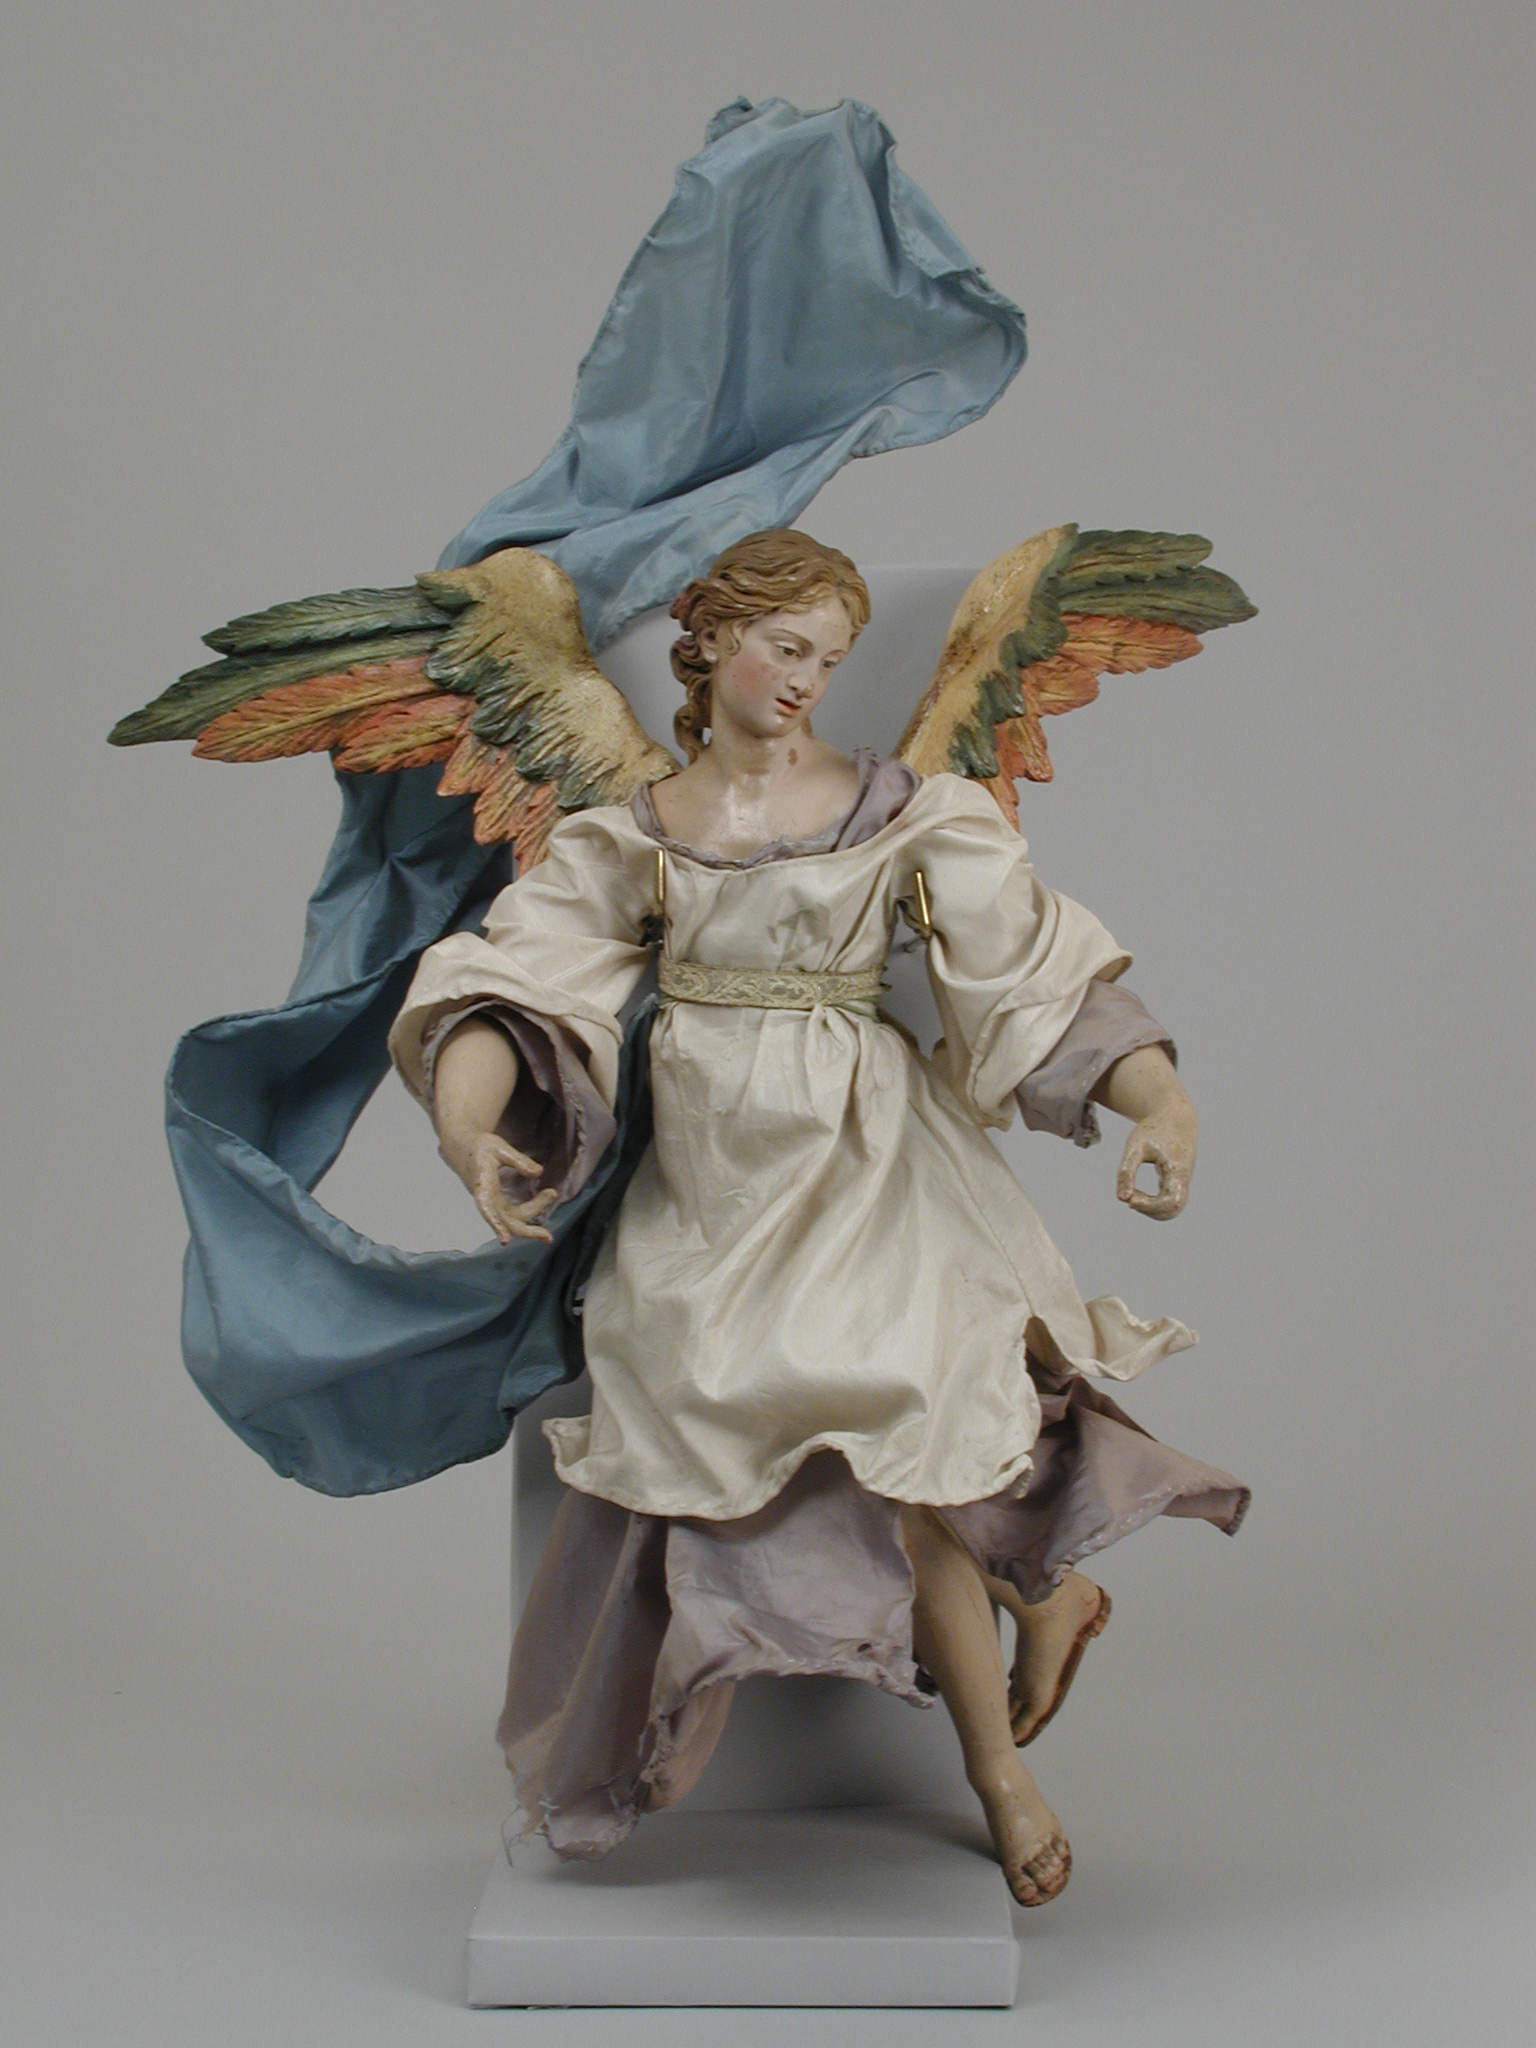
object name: crèche figure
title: Angel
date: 1751-1800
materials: terracotta, fiber, metal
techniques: polychrome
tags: angels